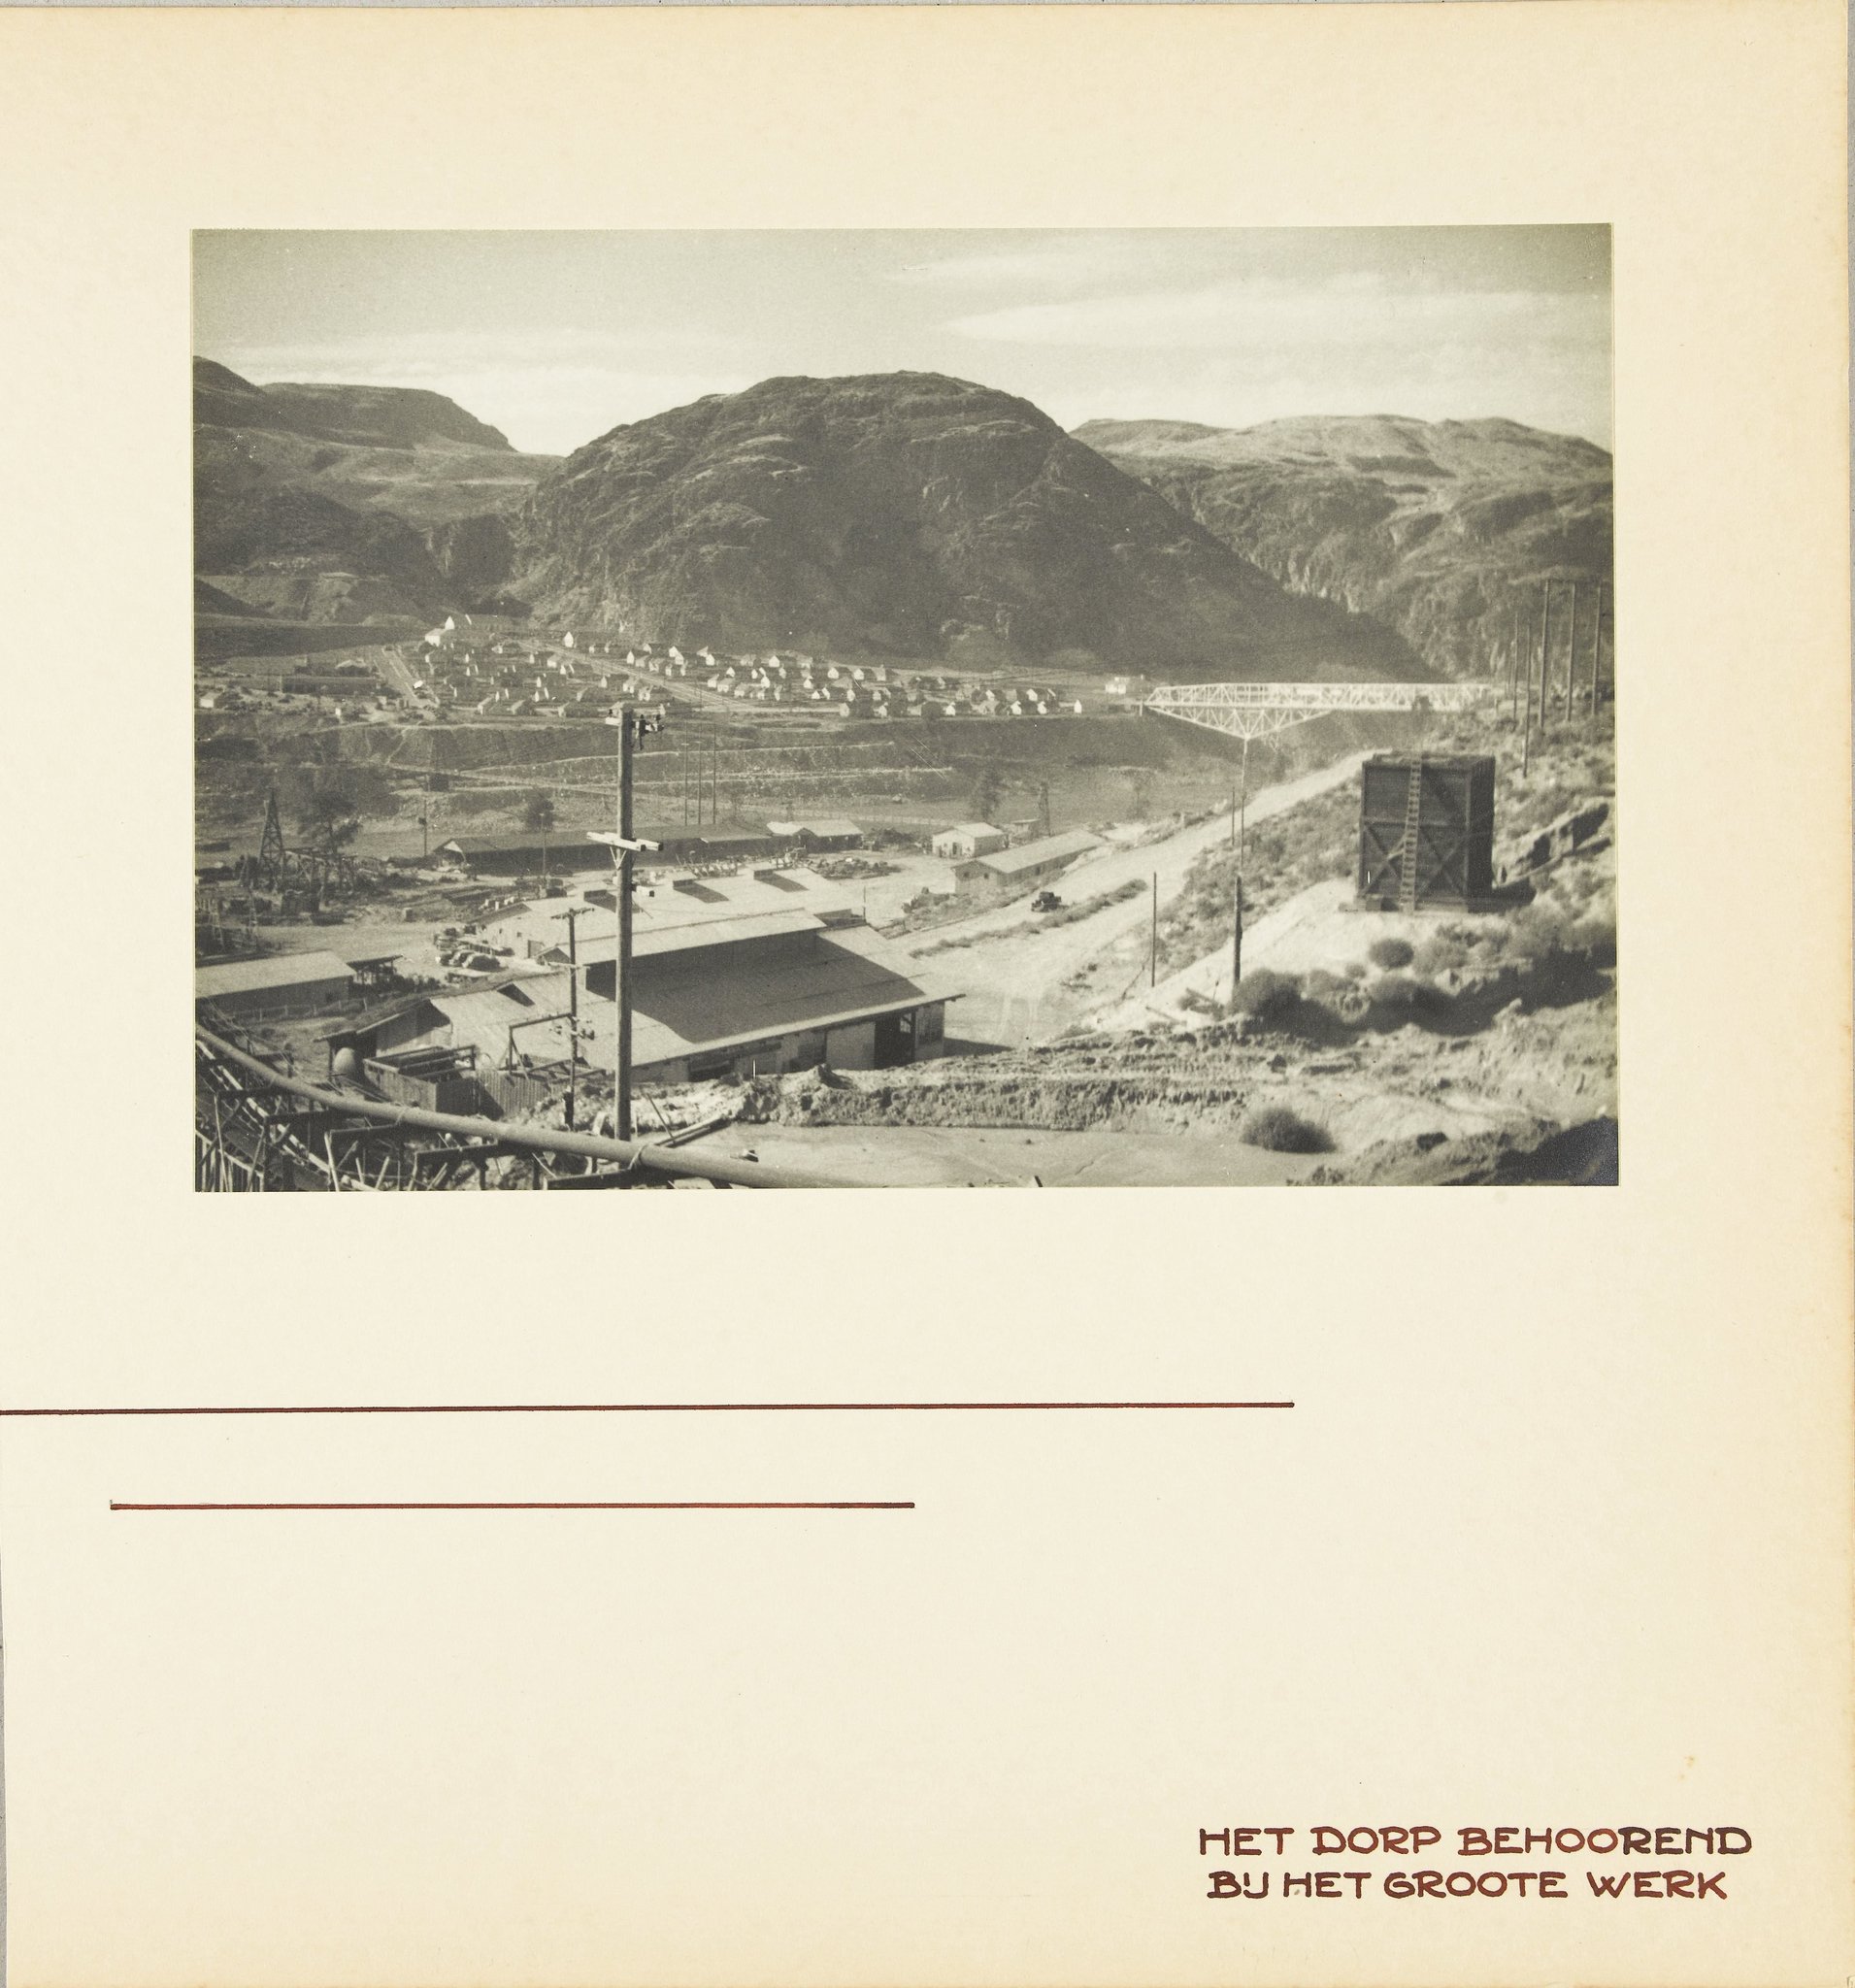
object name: photograph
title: Onbekende locatie in de Verenigde Staten: gezicht op 'het dorp behorend bij het grote werk'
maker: wouter cool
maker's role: engineer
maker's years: 1877-1947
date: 1936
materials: cardboard, paper, photographic support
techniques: gelatin silver print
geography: united states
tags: prospect of village, silhouette of village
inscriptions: title: ‘HET DORP BEHOOREND / BIJ HET GROOTE WERK’